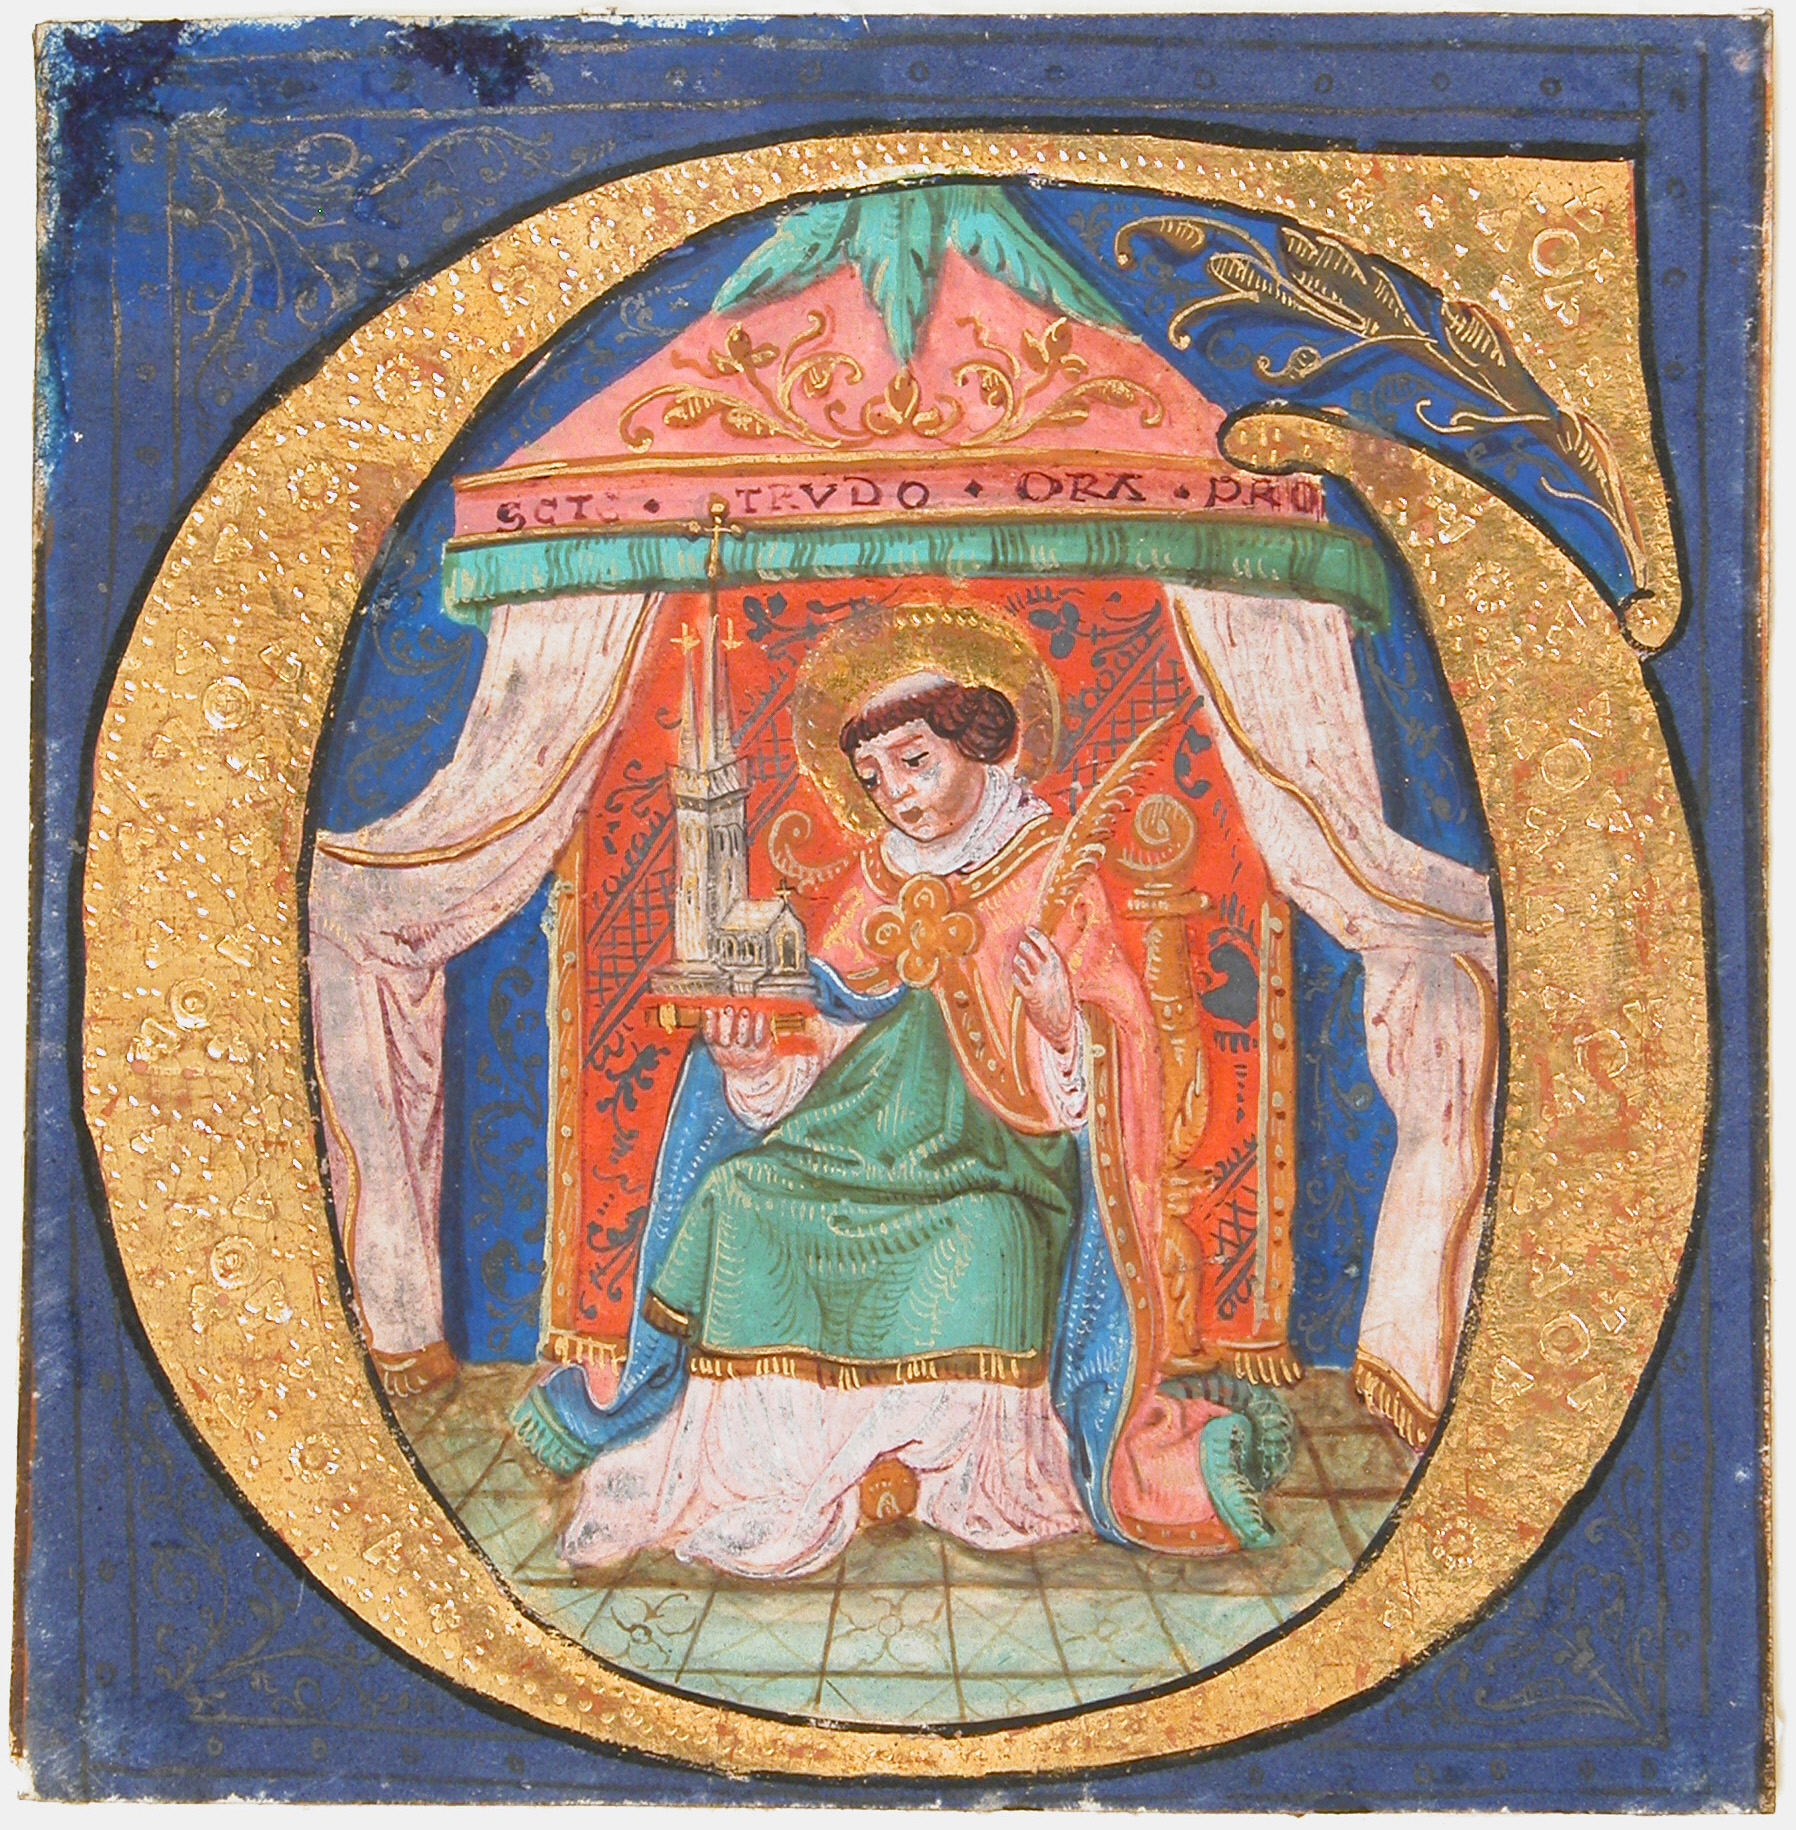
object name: choir book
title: Manuscript Illumination with Saint Trudo (Trond) in an Initial O, from a Choir Book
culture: german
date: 1401-1500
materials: gold, ink, parchment, paint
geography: germany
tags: men,saints